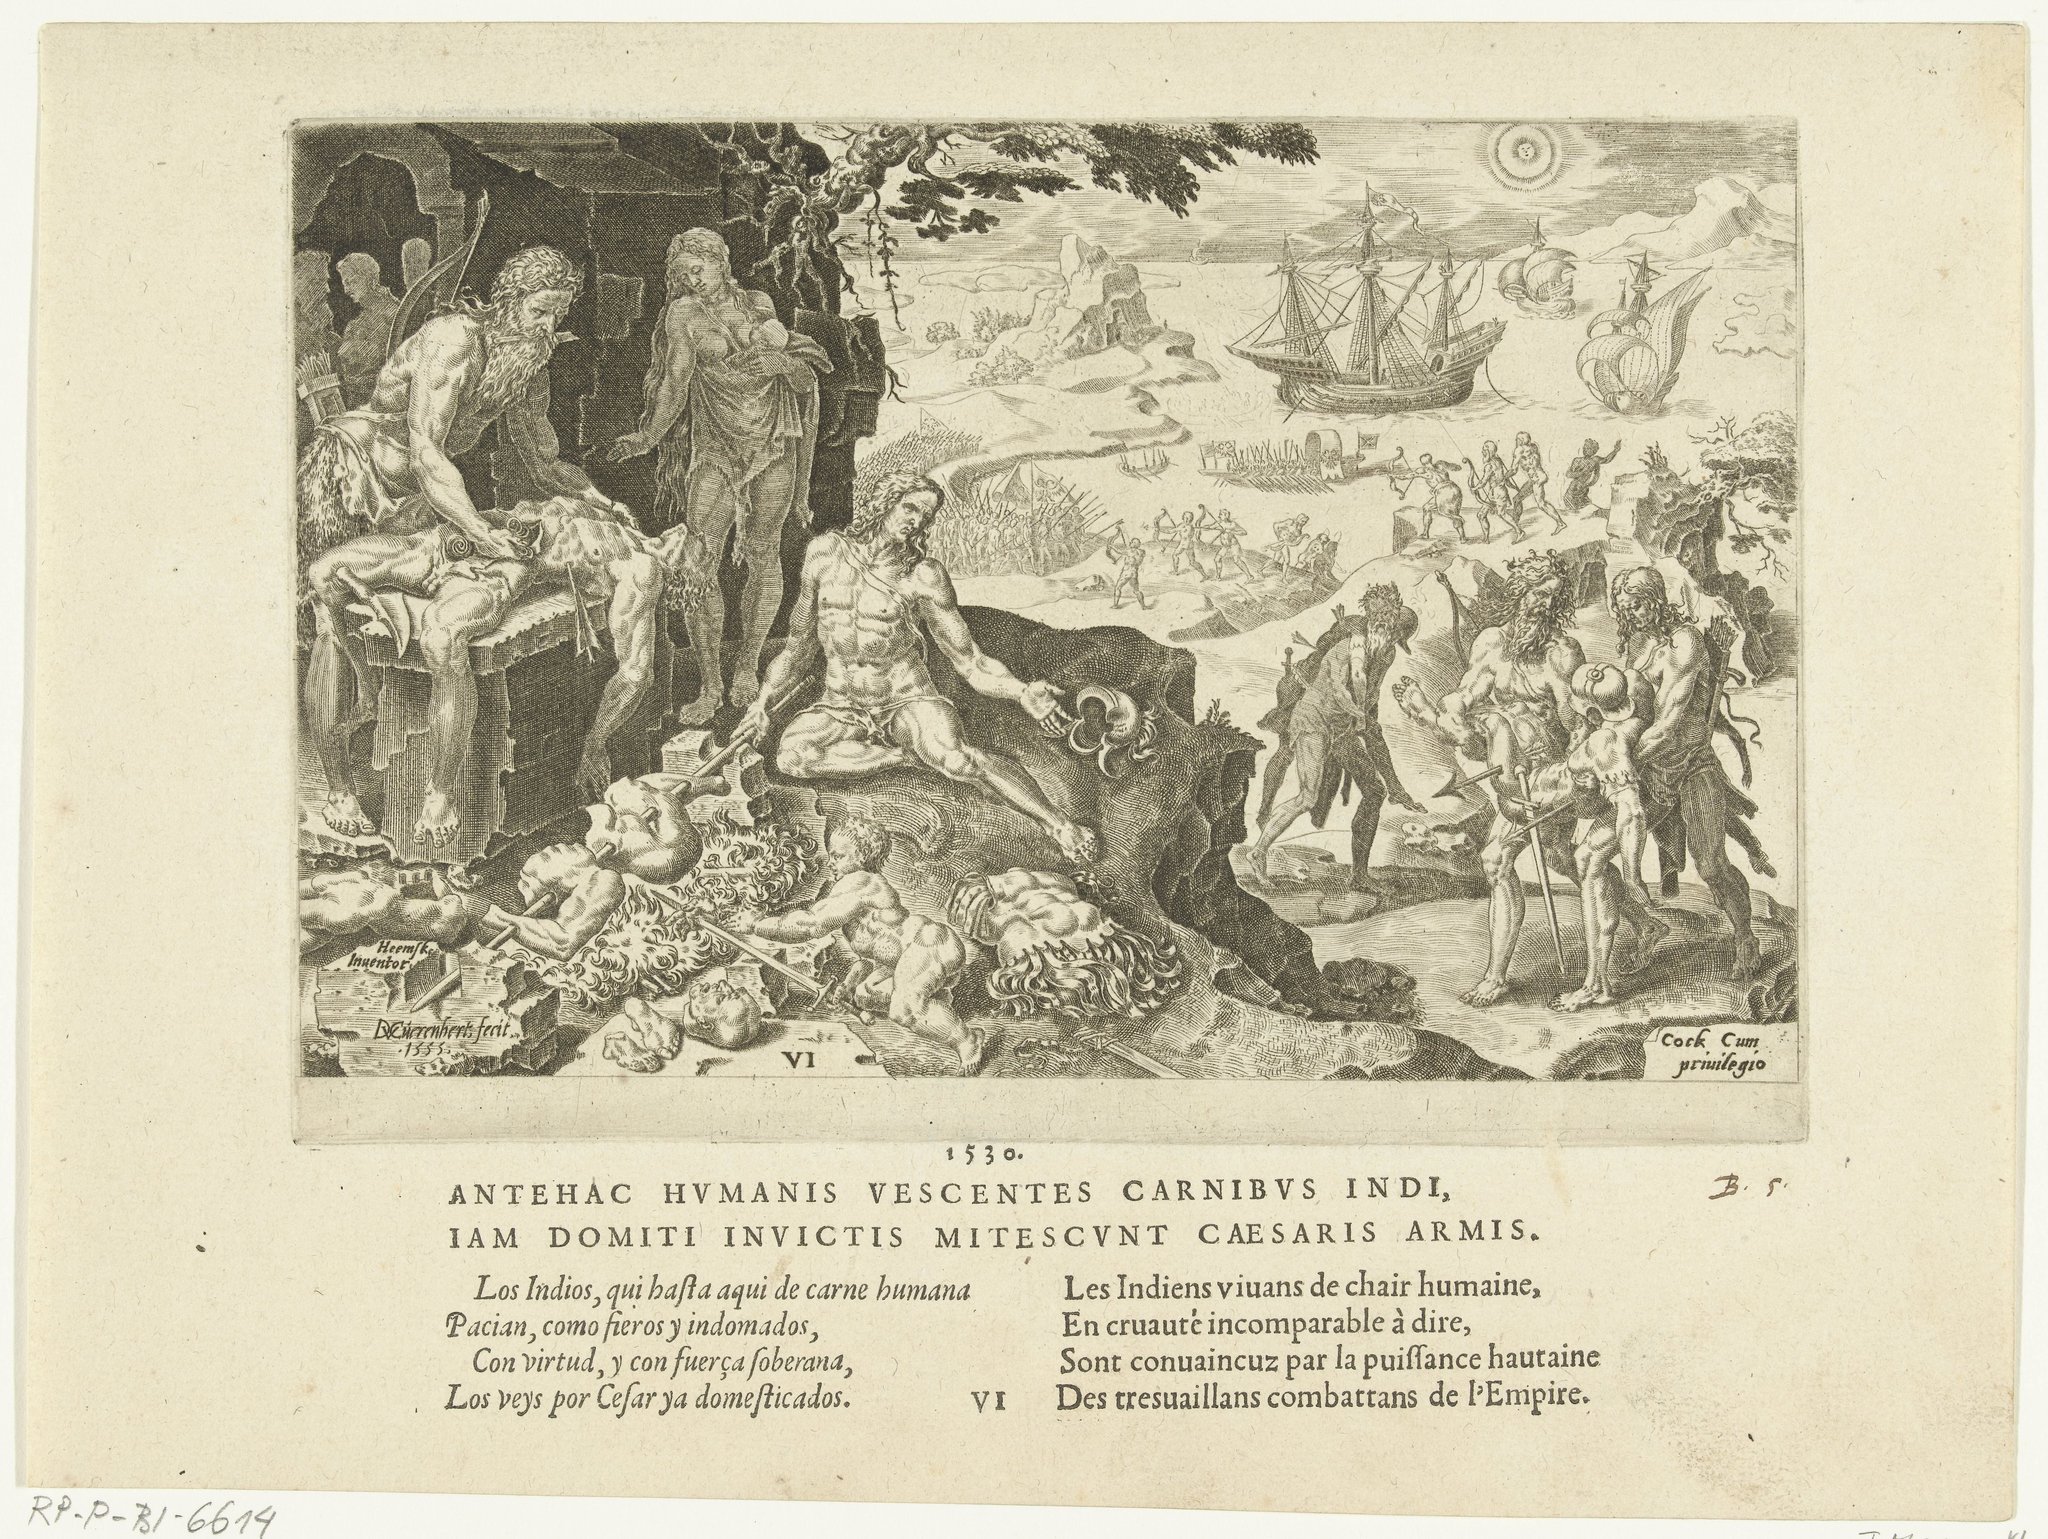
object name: history print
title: Troepen van keizer Karel V vallen Centraal-Amerika binnen, 1530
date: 1555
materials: paper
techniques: engraving, etching, letterpress printing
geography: antwerp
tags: ghent, charles v (holy roman emperor and king of spain), battle, indigenous peoples of central america, cannibalism, violent death by disembowelment, pulling out of intestines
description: Keizerlijke troepen van Karel V vallen Centraal-Amerika binnen, 1530. De oorspronkelijke bevolking van toenmalig Nieuw-Spanje, nu Mexico, bedrijft kannibalisme. Op de voorgrond wordt links een Spaanse soldaat ontdaan van zijn organen en worden ledematen van andere soldaten geroosterd. Rechts worden nog twee gedode soldaten naar die plek gebracht. Op de achtergrond vechten Spaanse soldaten en de lokale bevolking een veldslag uit. Onderschrift in twee regels Latijn, vier regels Spaans en vier regels Frans.